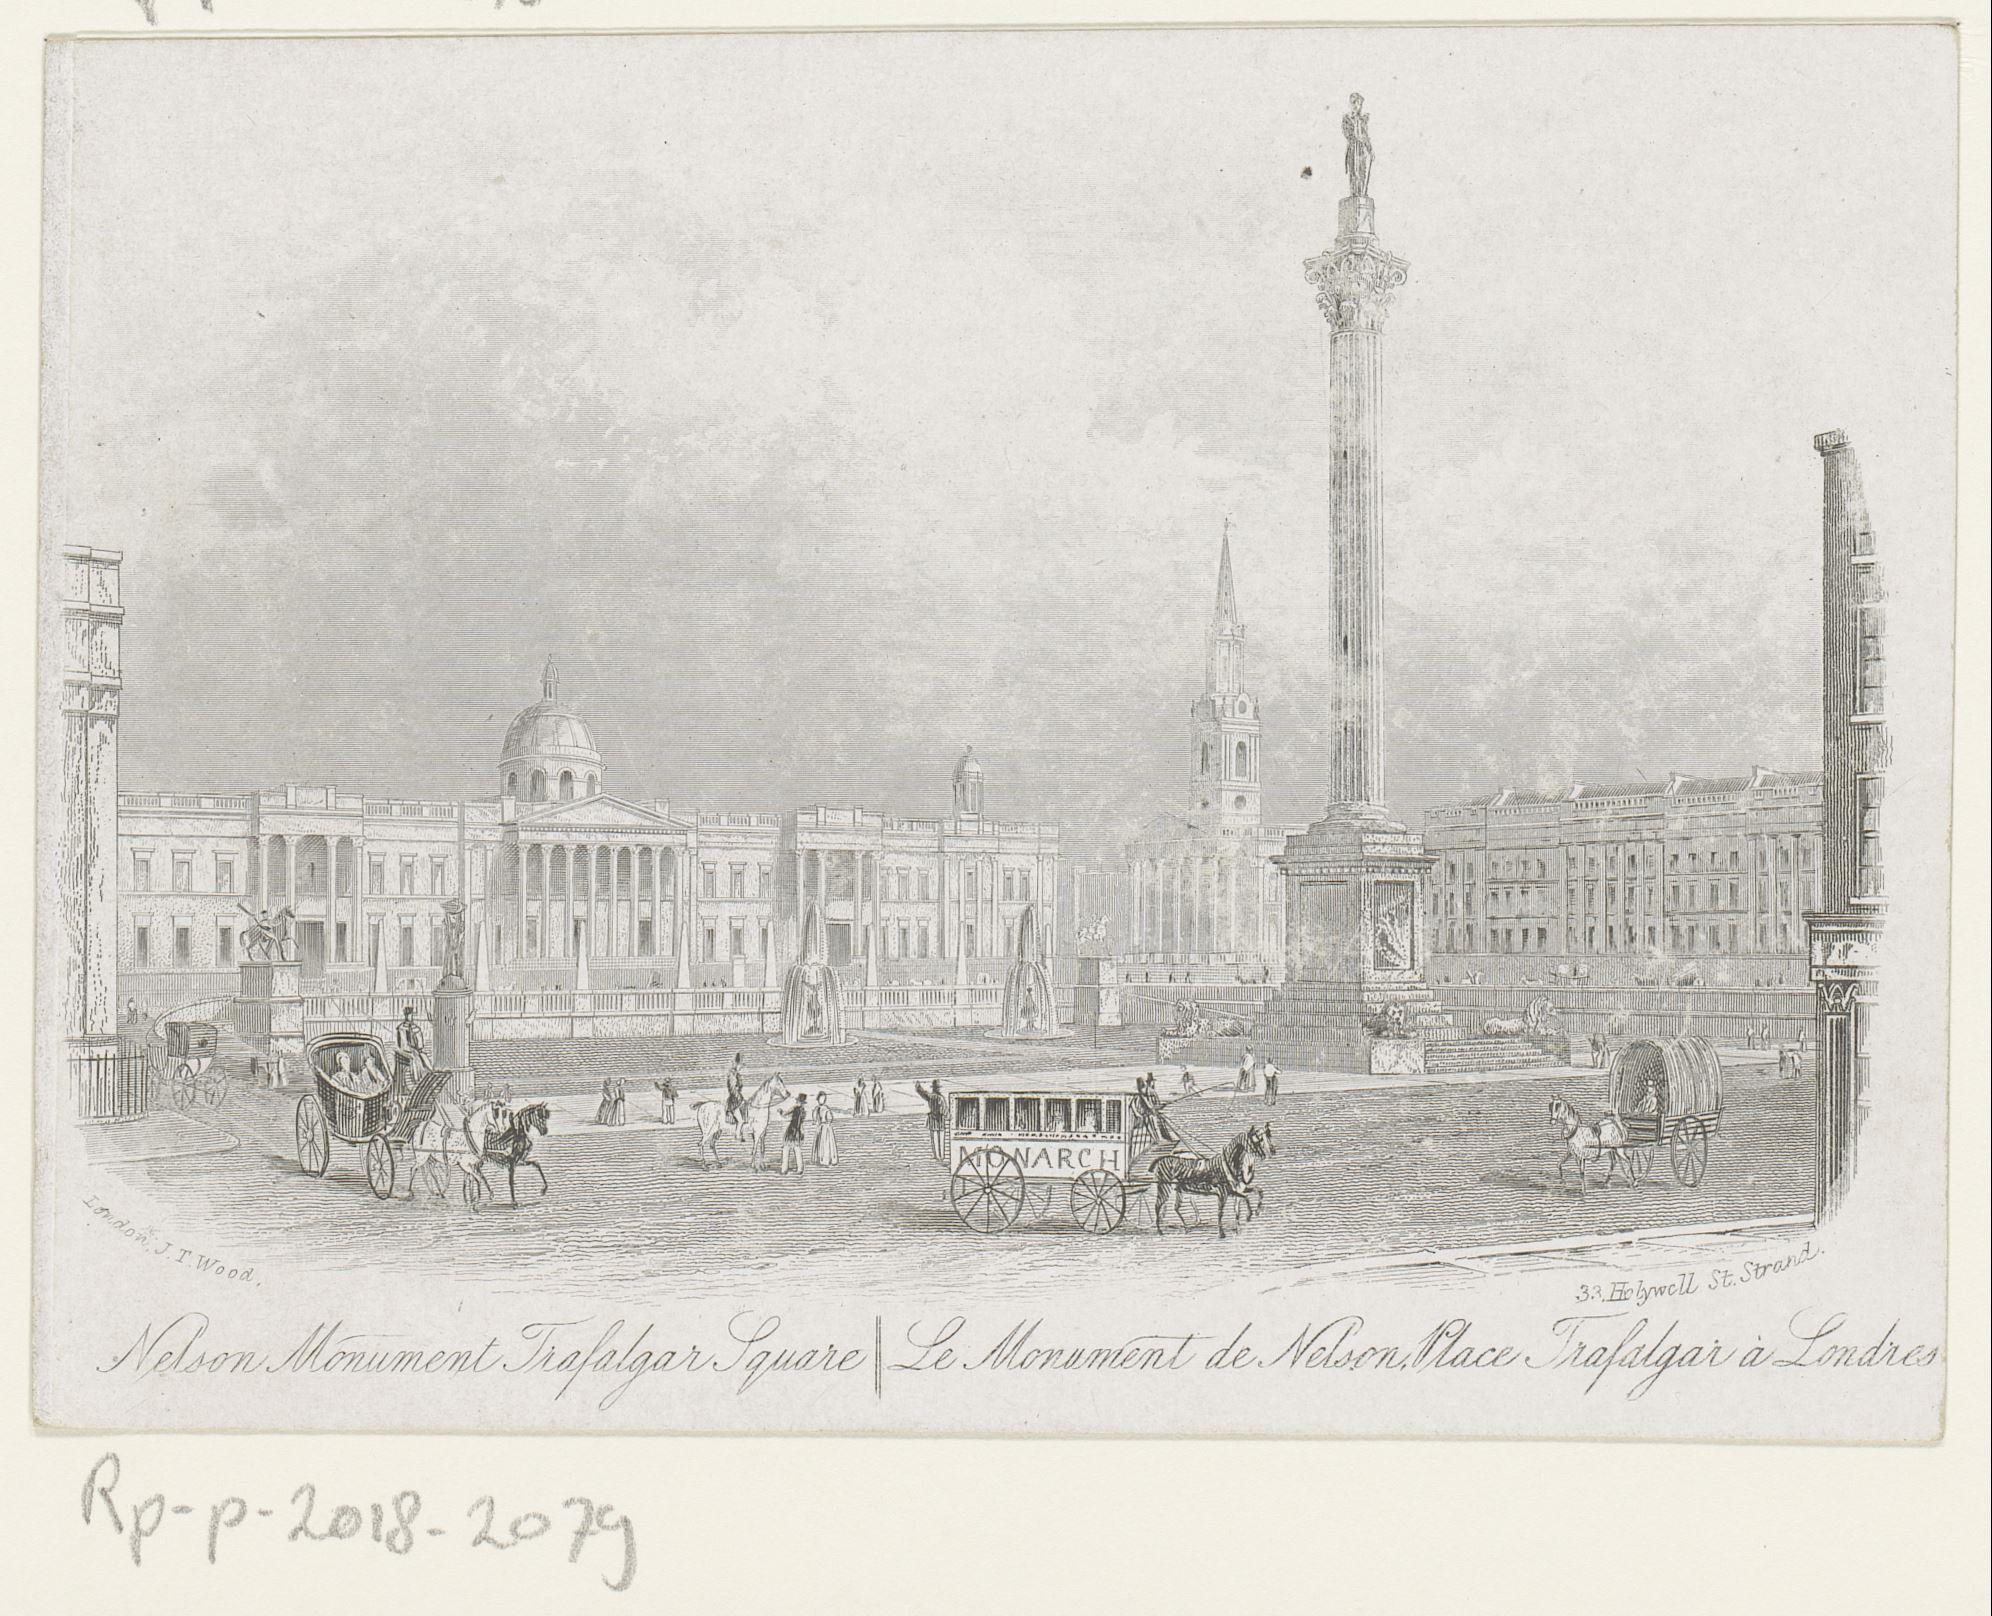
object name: print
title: Nelsons Monument, Trafalgar Square / Le Monument de Nelson, Place Trafalgar à Londres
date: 1843-1885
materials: paper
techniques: etching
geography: london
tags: column, pillar ~ architecture, monument, statue